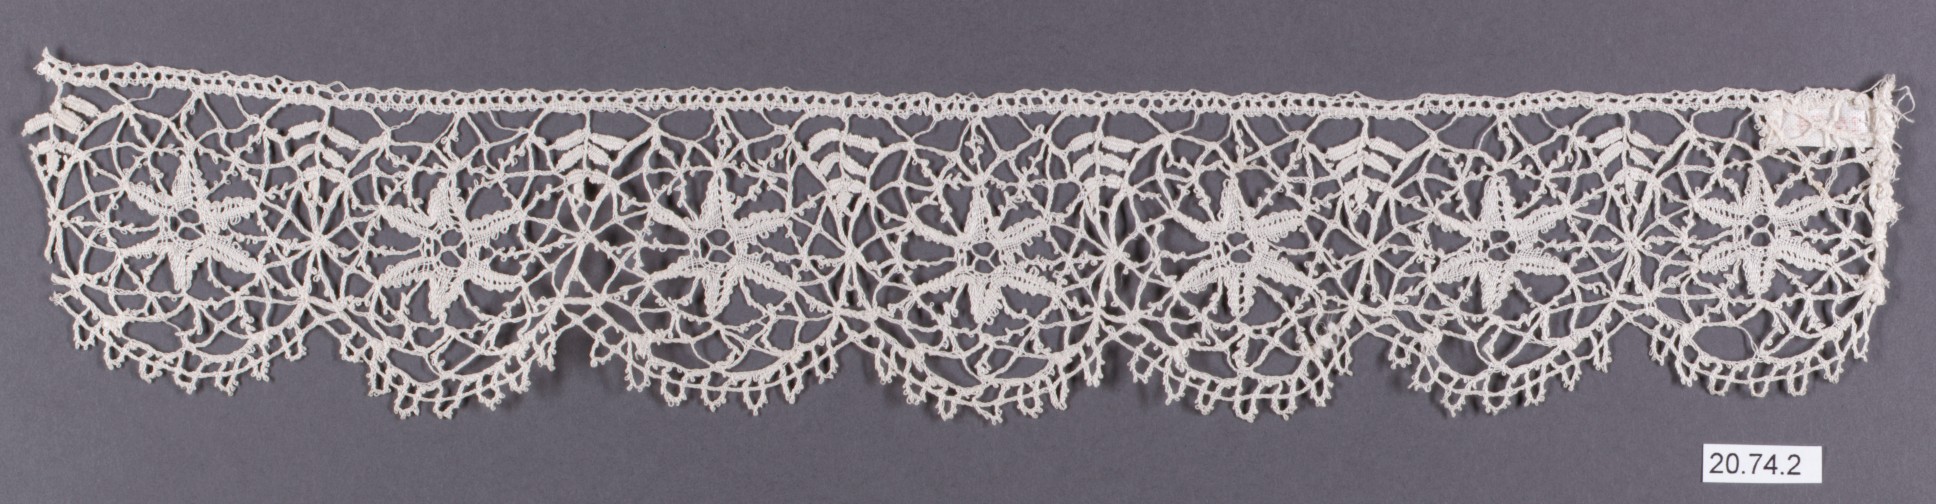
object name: fragment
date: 1701-1800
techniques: lace